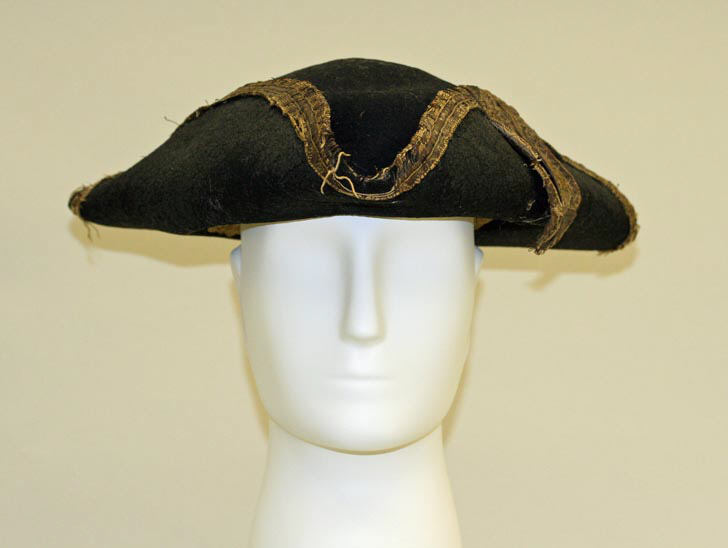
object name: tricorne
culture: american or european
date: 1734-1766